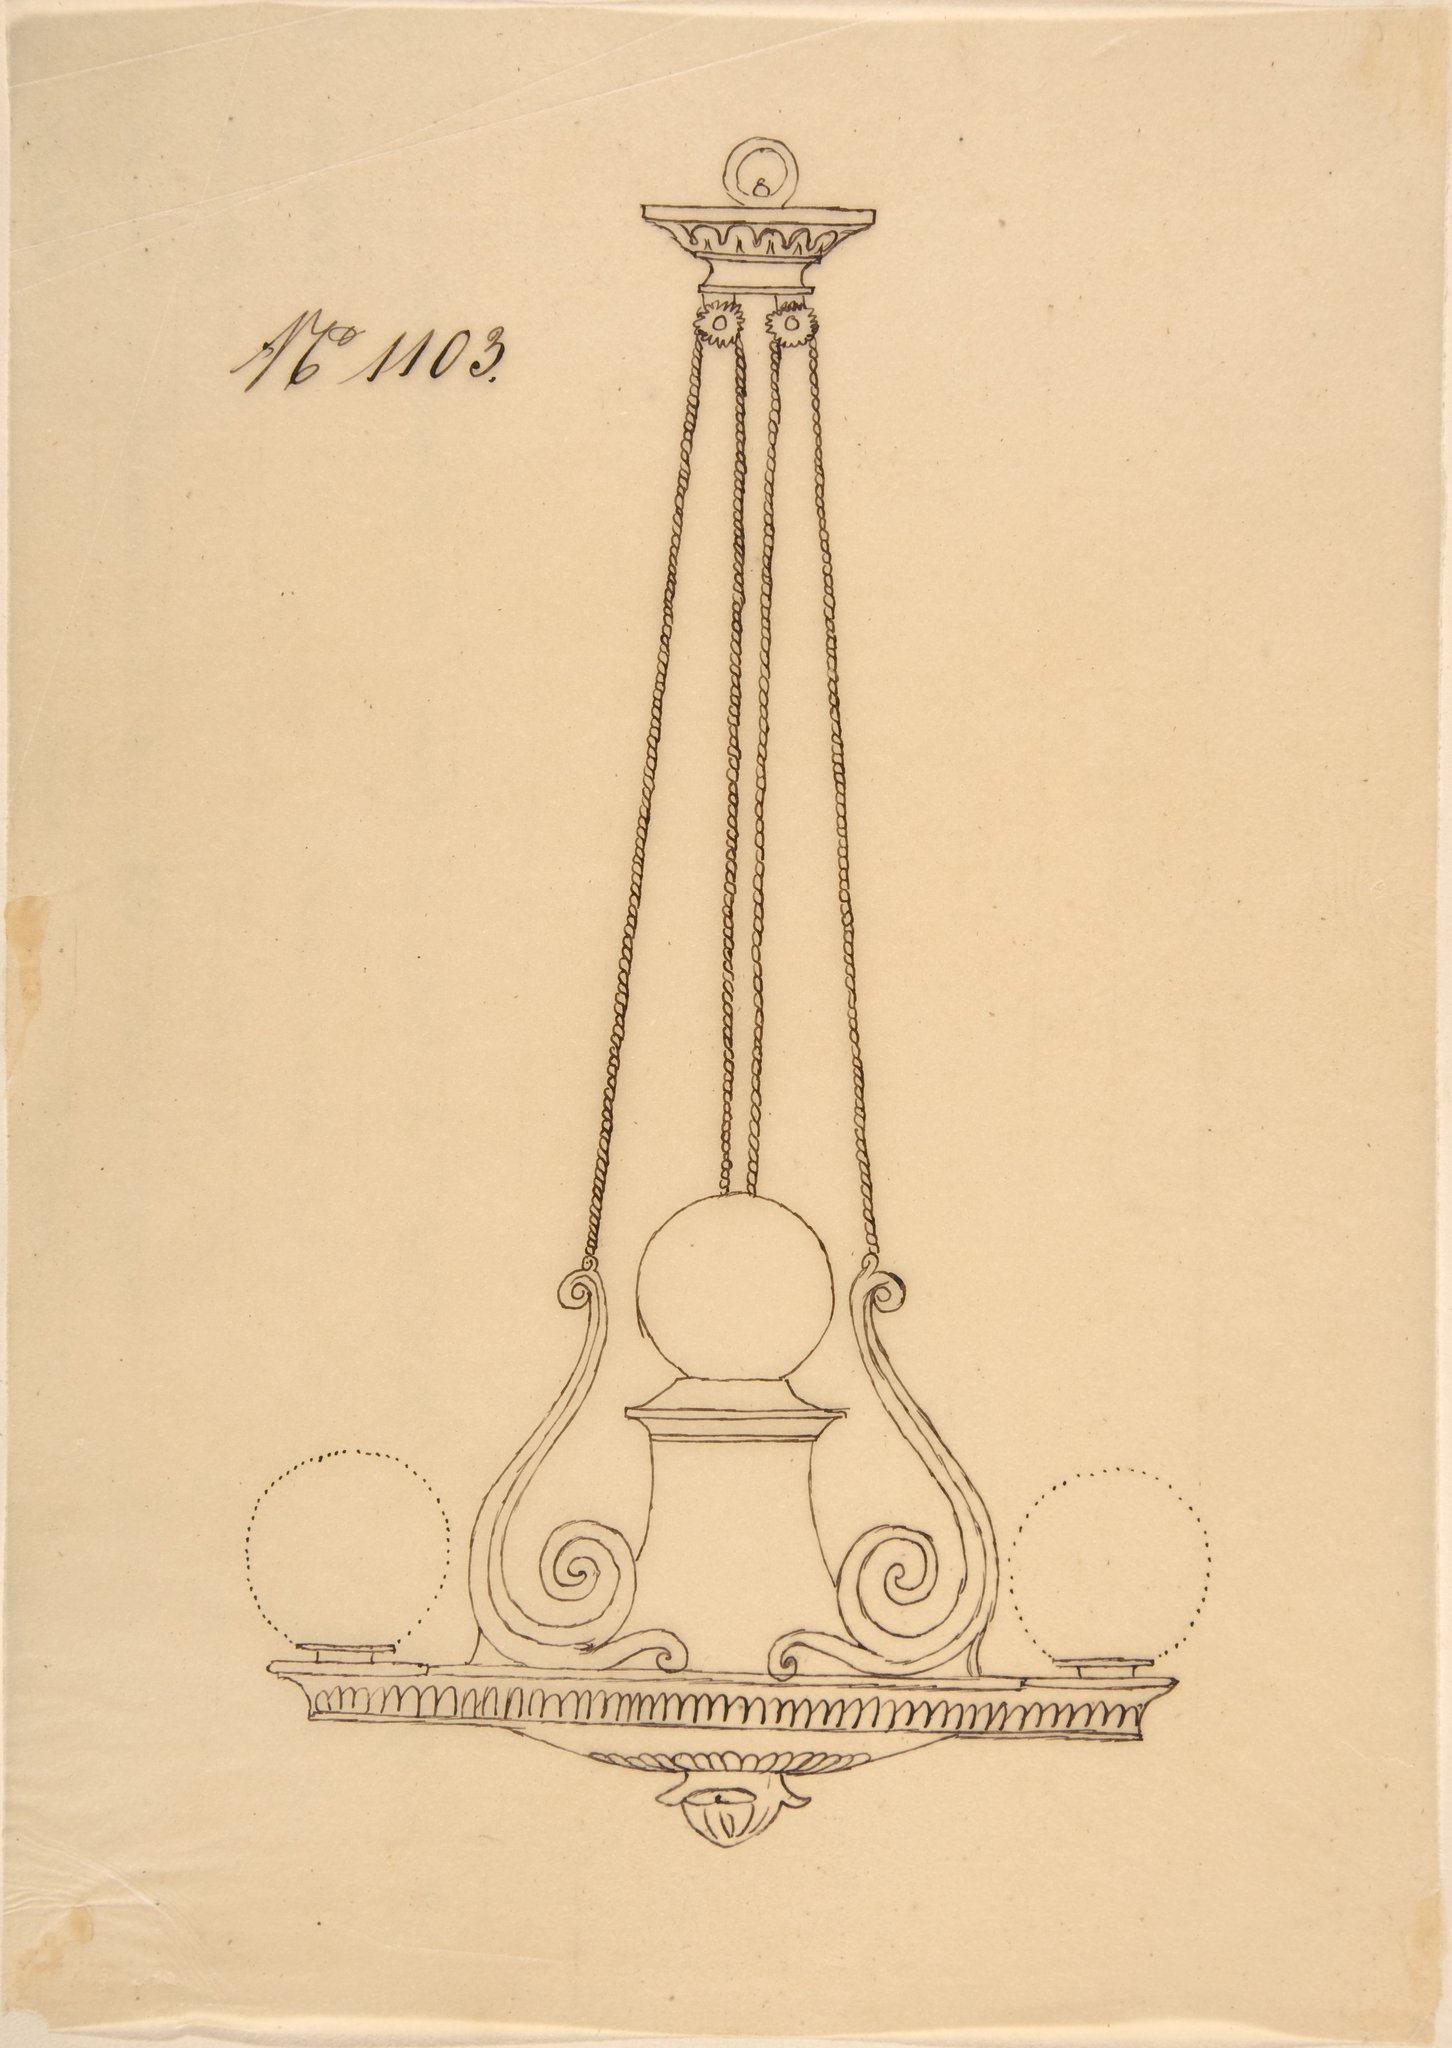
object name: drawing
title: Design for a Chandelier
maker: anonymous, french, 19th century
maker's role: artist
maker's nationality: french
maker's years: 1800-1900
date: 1801-1900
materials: ink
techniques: pen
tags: chandelier